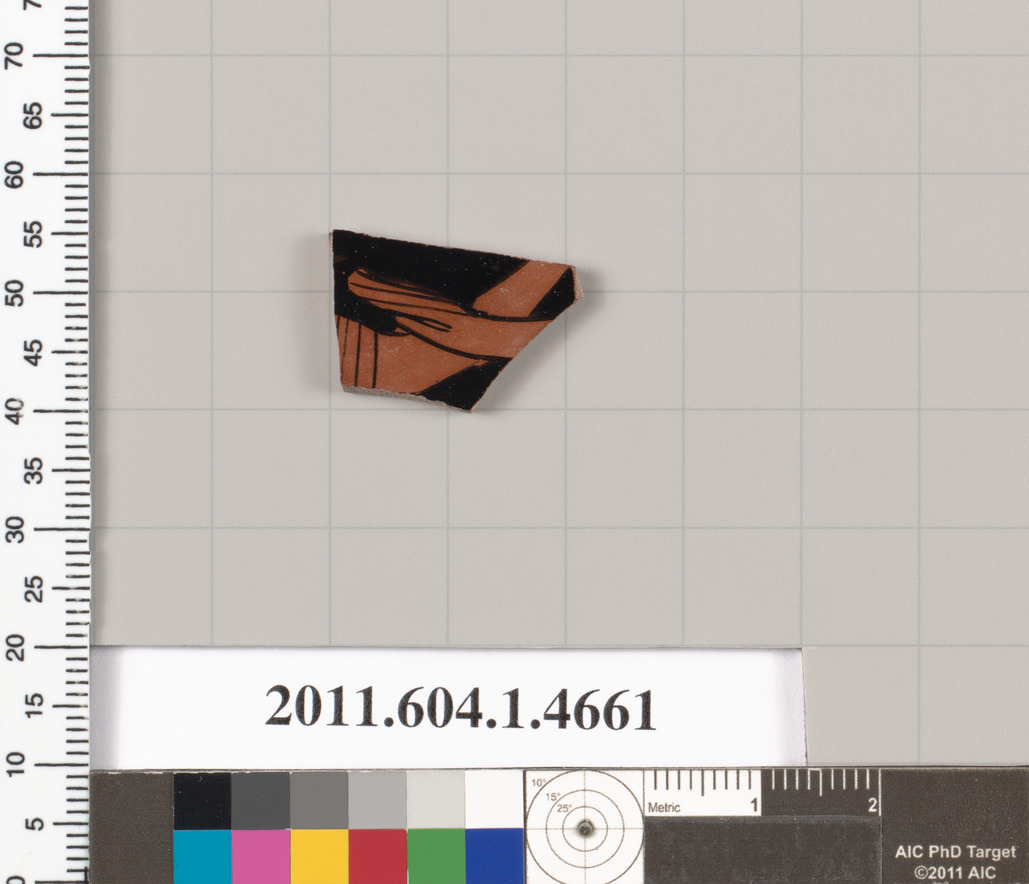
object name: kylix fragment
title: Terracotta fragment of a kylix (drinking cup)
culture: greek, attic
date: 520-500 BCE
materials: terracotta